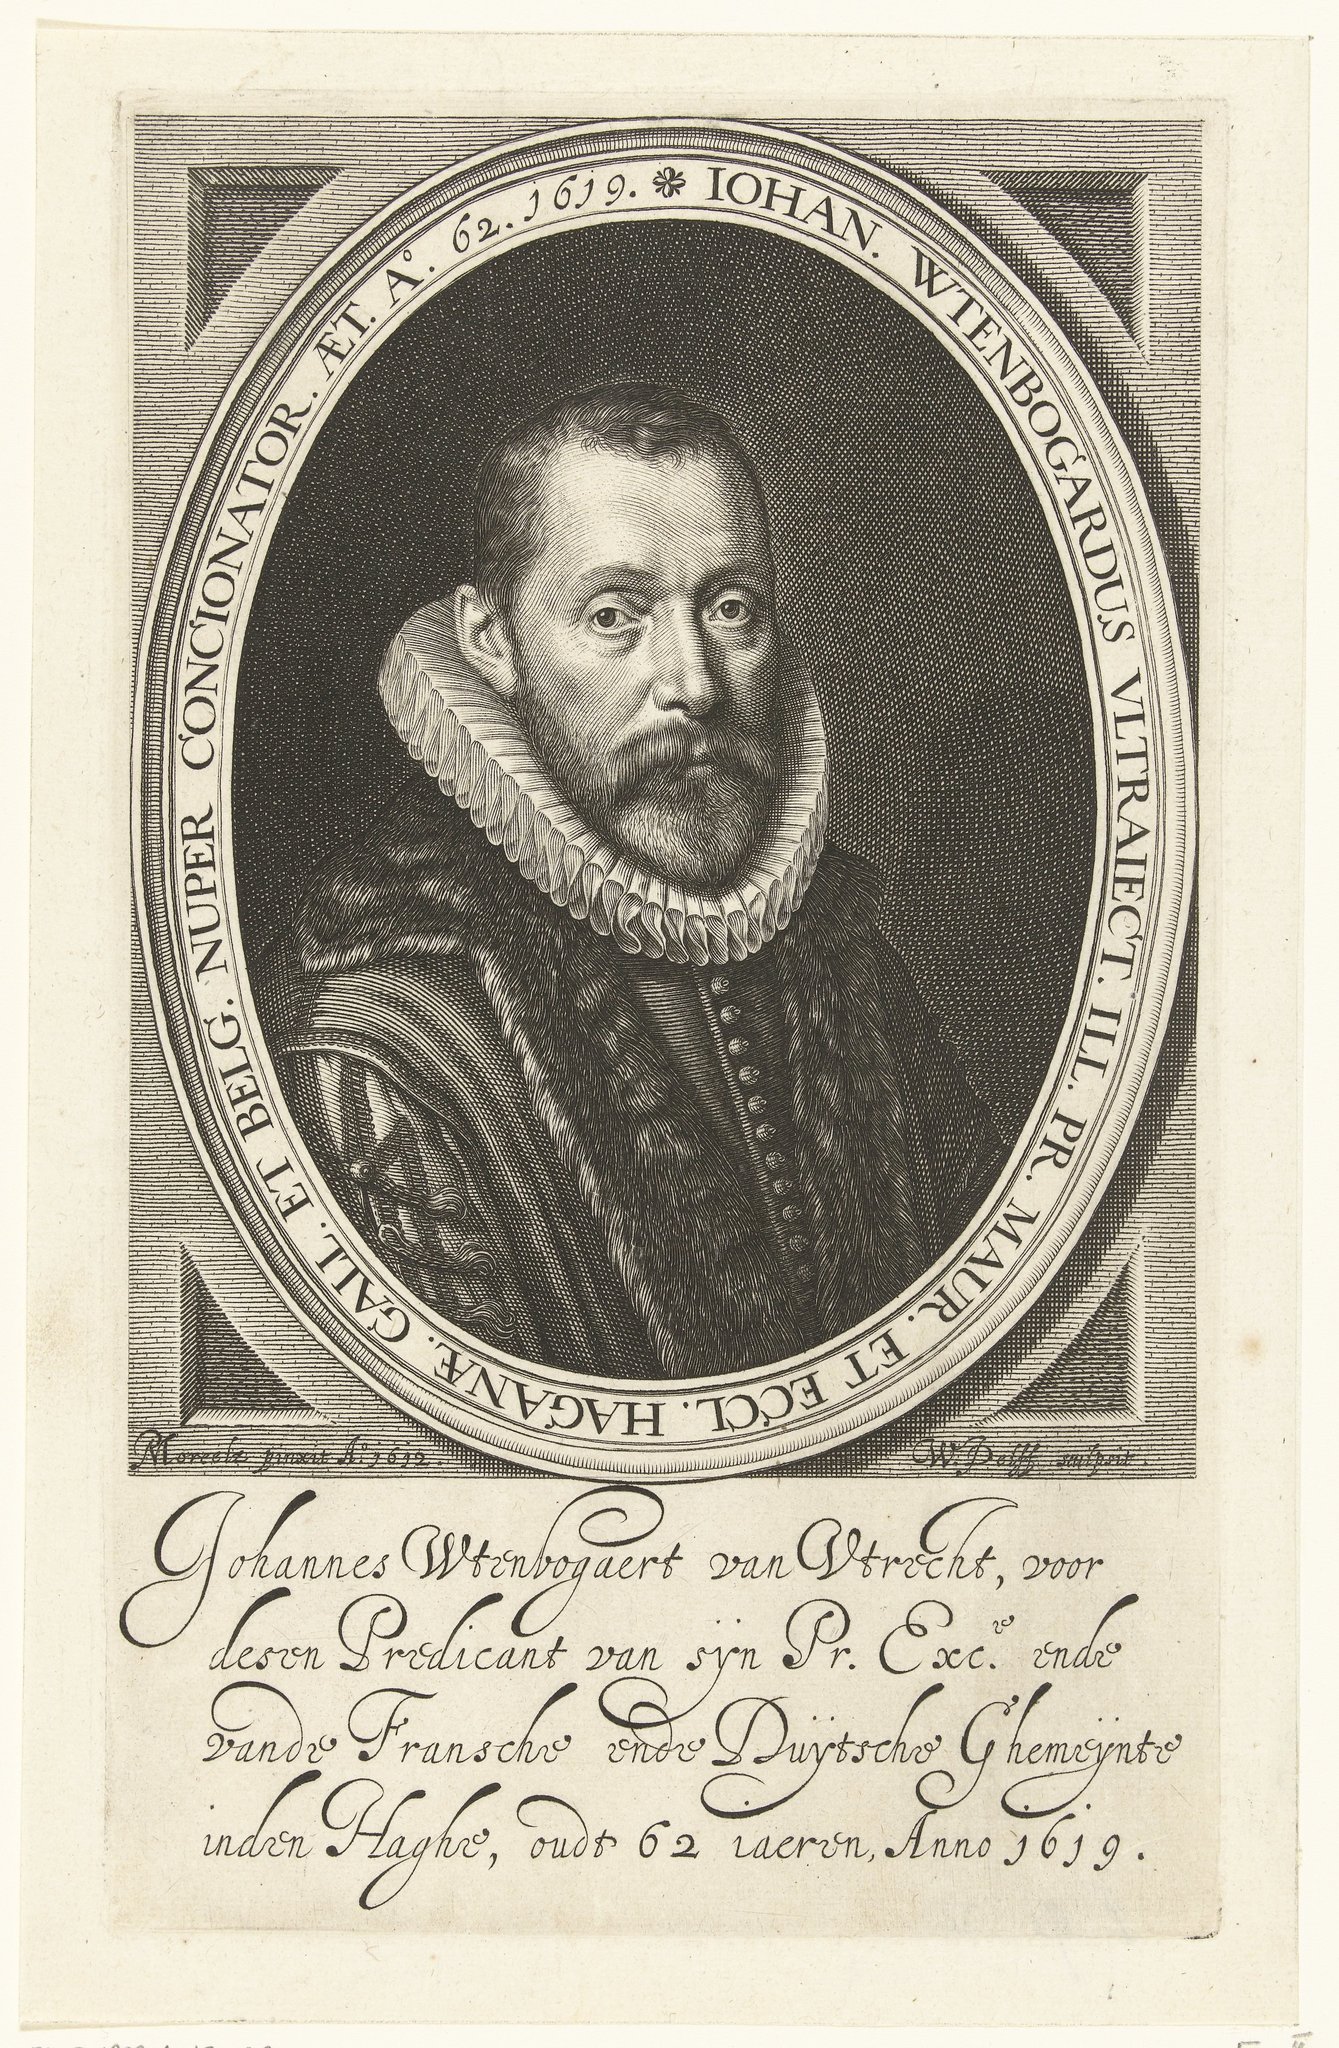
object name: print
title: Portret van Johannes Wtenbogaert op 62-jarige leeftijd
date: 1619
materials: paper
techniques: engraving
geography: delft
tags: utrecht, the hague, functionaries and dignitaries (with name) ~ episcopal protestant churches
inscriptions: collector's mark: Lugt 2228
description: Portret van predikant Johannes Wtenbogaert op 62-jarige leeftijd, borststuk met molenkraag en toga, in ovale omlijsting met Latijns opschrift. In ondermarge vier regels Latijns opschrift.